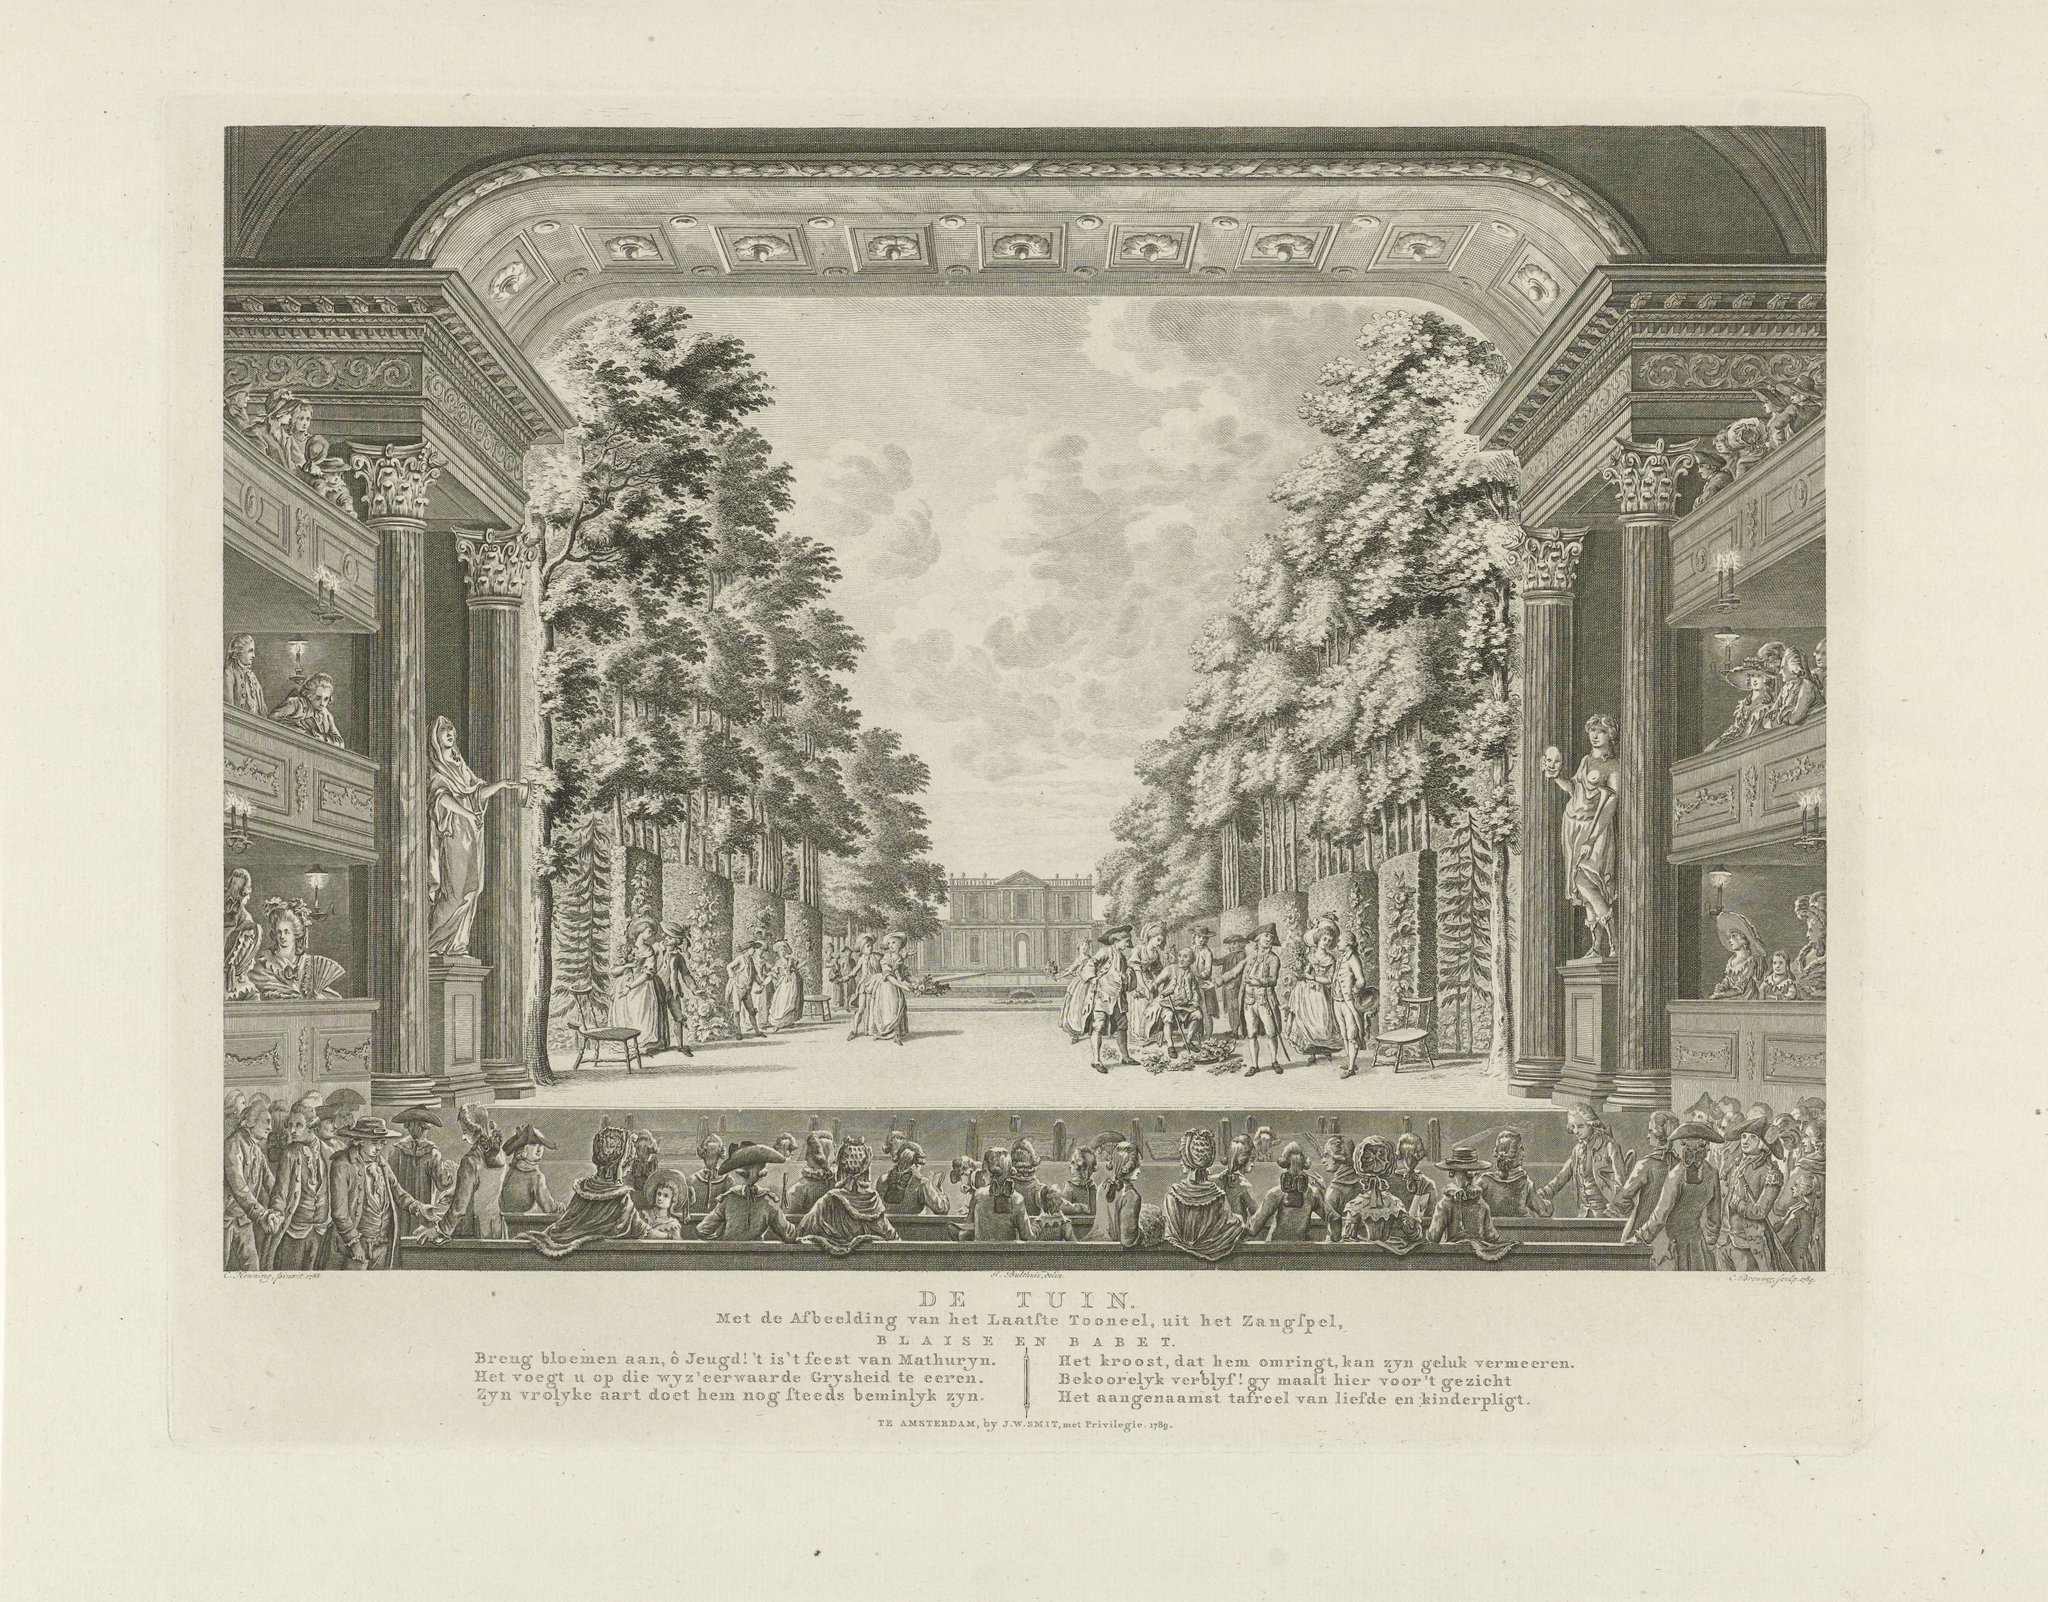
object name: print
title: De Tuin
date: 1789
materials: paper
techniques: engraving, etching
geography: amsterdam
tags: theatre, theatrical performance, stage design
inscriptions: collector's mark: Lugt 2228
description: Toneelvoorstelling in de nieuwe Amsterdamse Schouwburg met het coulissendecor De Tuin, met scène uit Blaise en Babet. Het decor gedrukt van een aparte plaat binnen een vernieuwde passe-partout met de zaal, zijloges, pilaren met standbeelden en de façade van het toneel. In het onderschrift een zesregelig vers. Onderdeel van de serie van veertien toneeldecors van de nieuwe Amsterdamse Schouwburg, 1787-1794.